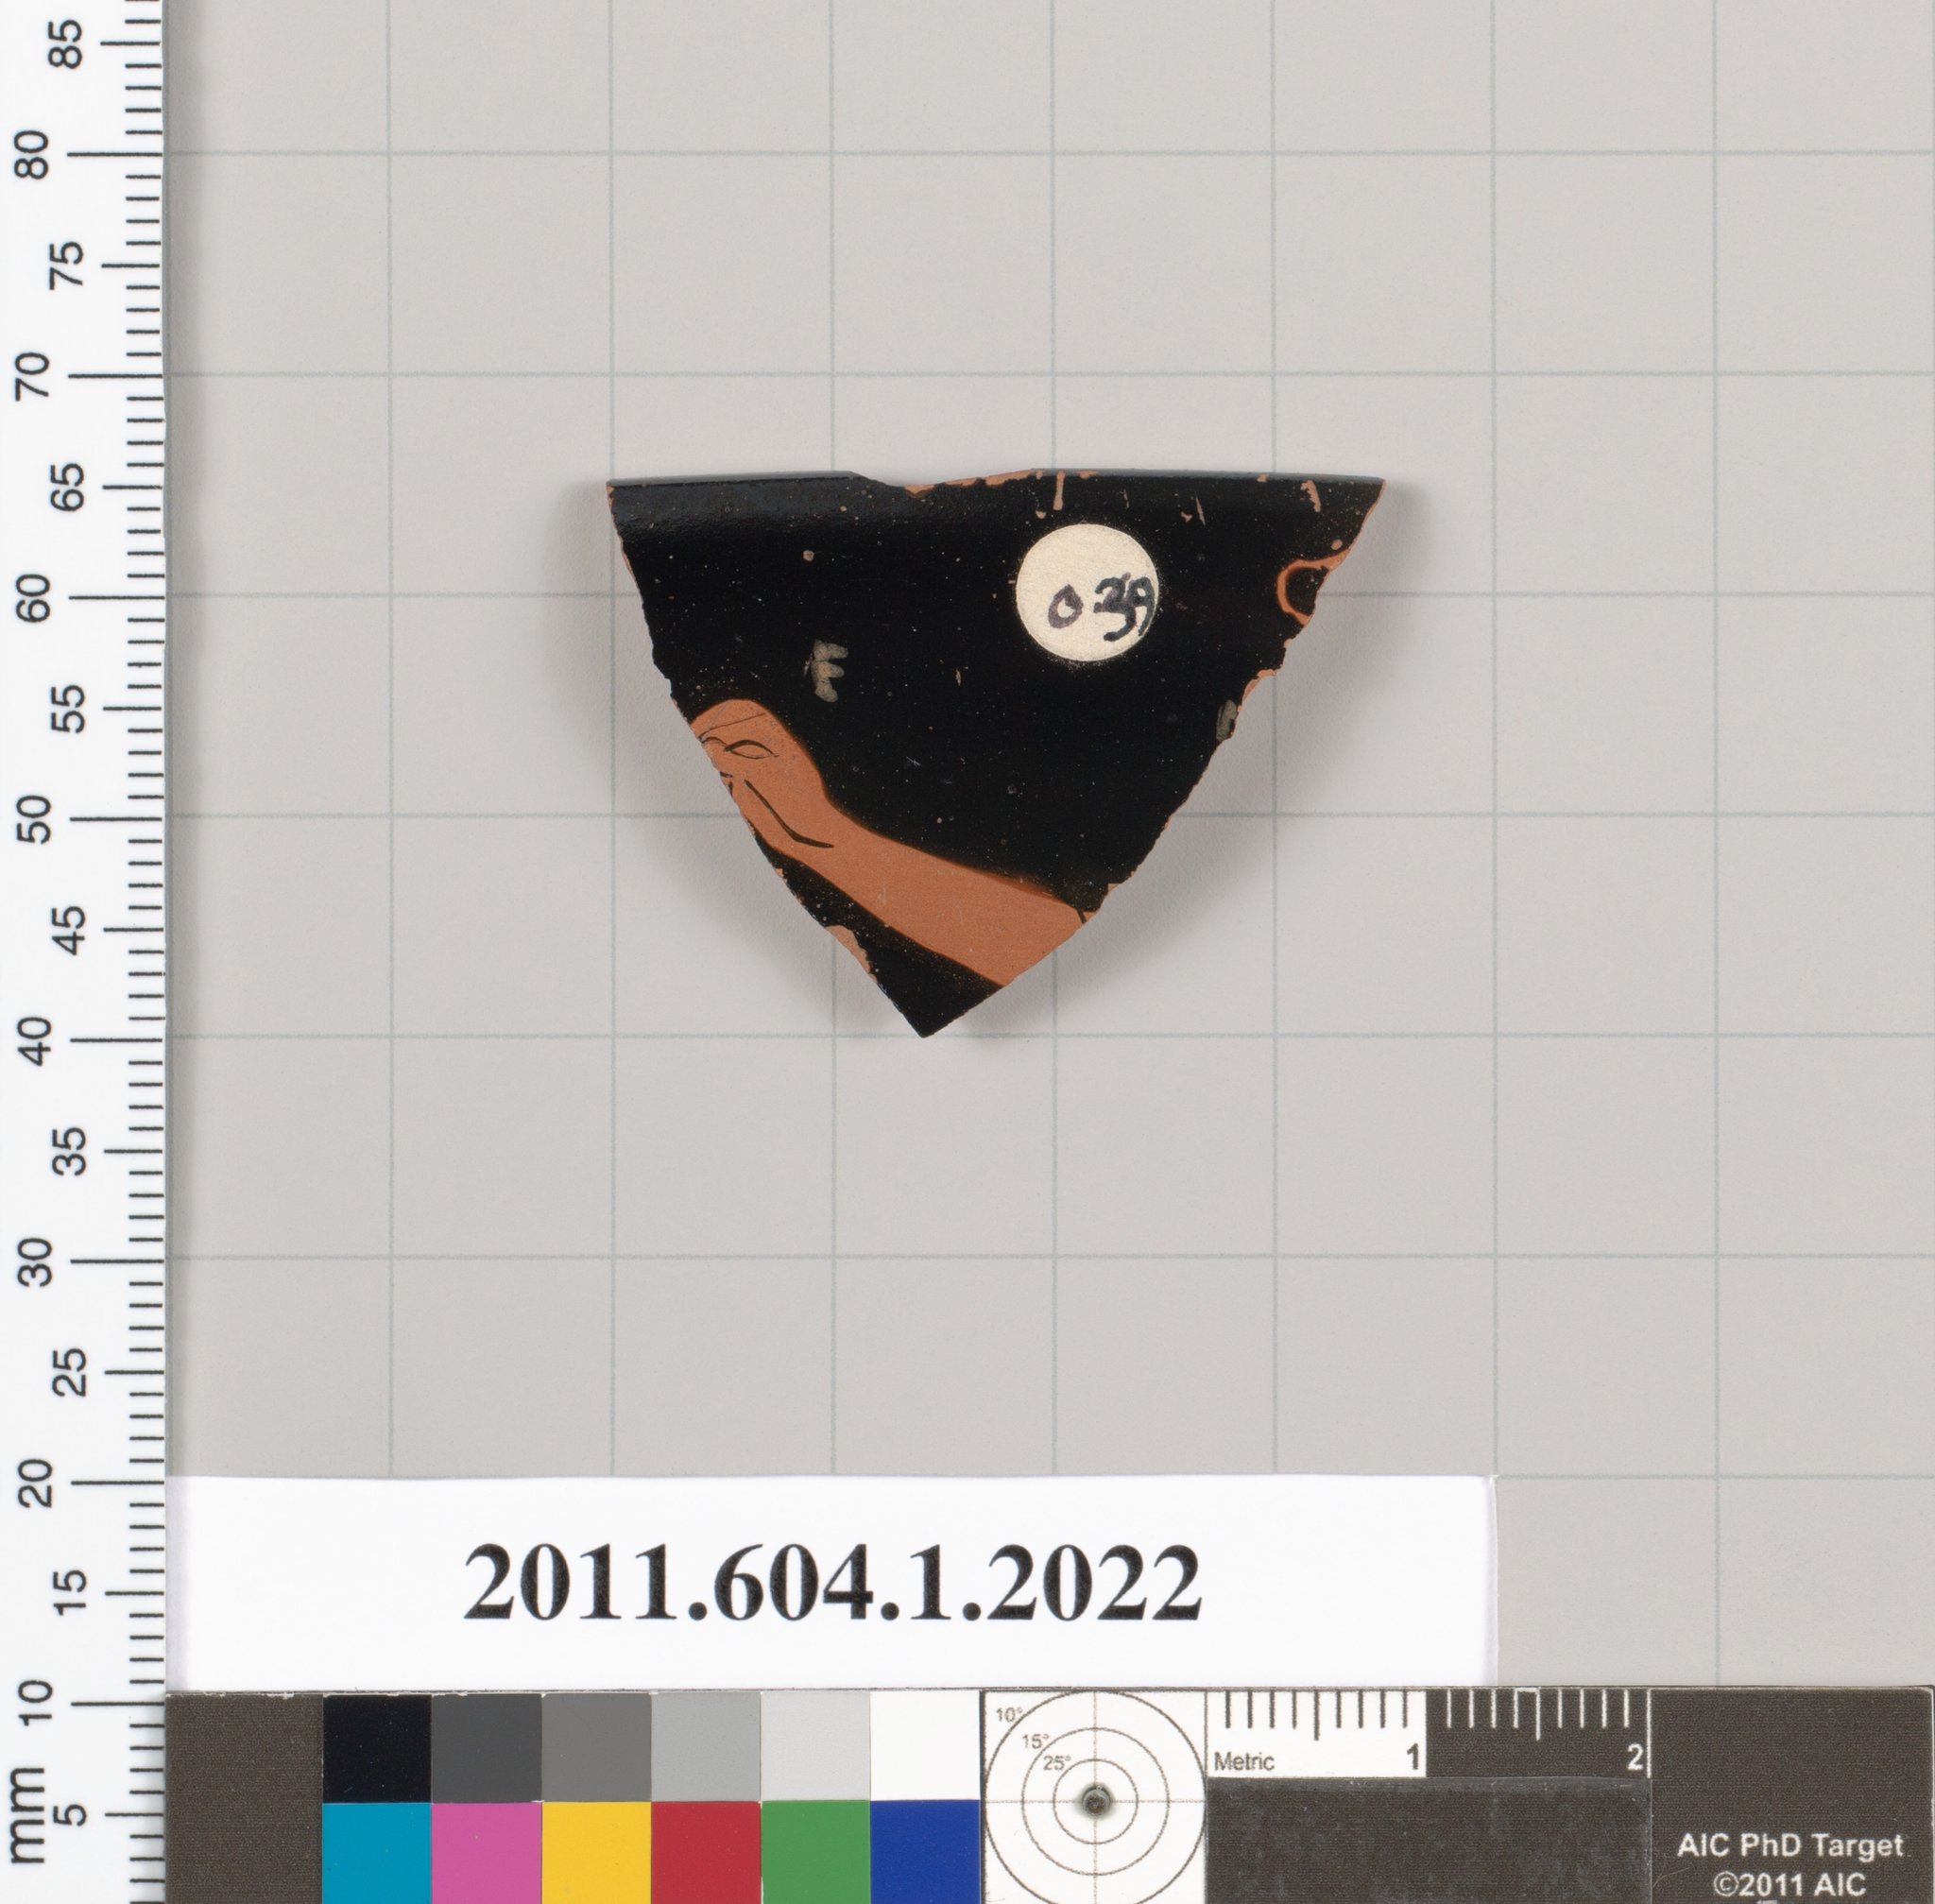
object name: kylix fragment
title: Terracotta rim fragment of a kylix (drinking cup)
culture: greek, attic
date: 475-451 BCE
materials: terracotta